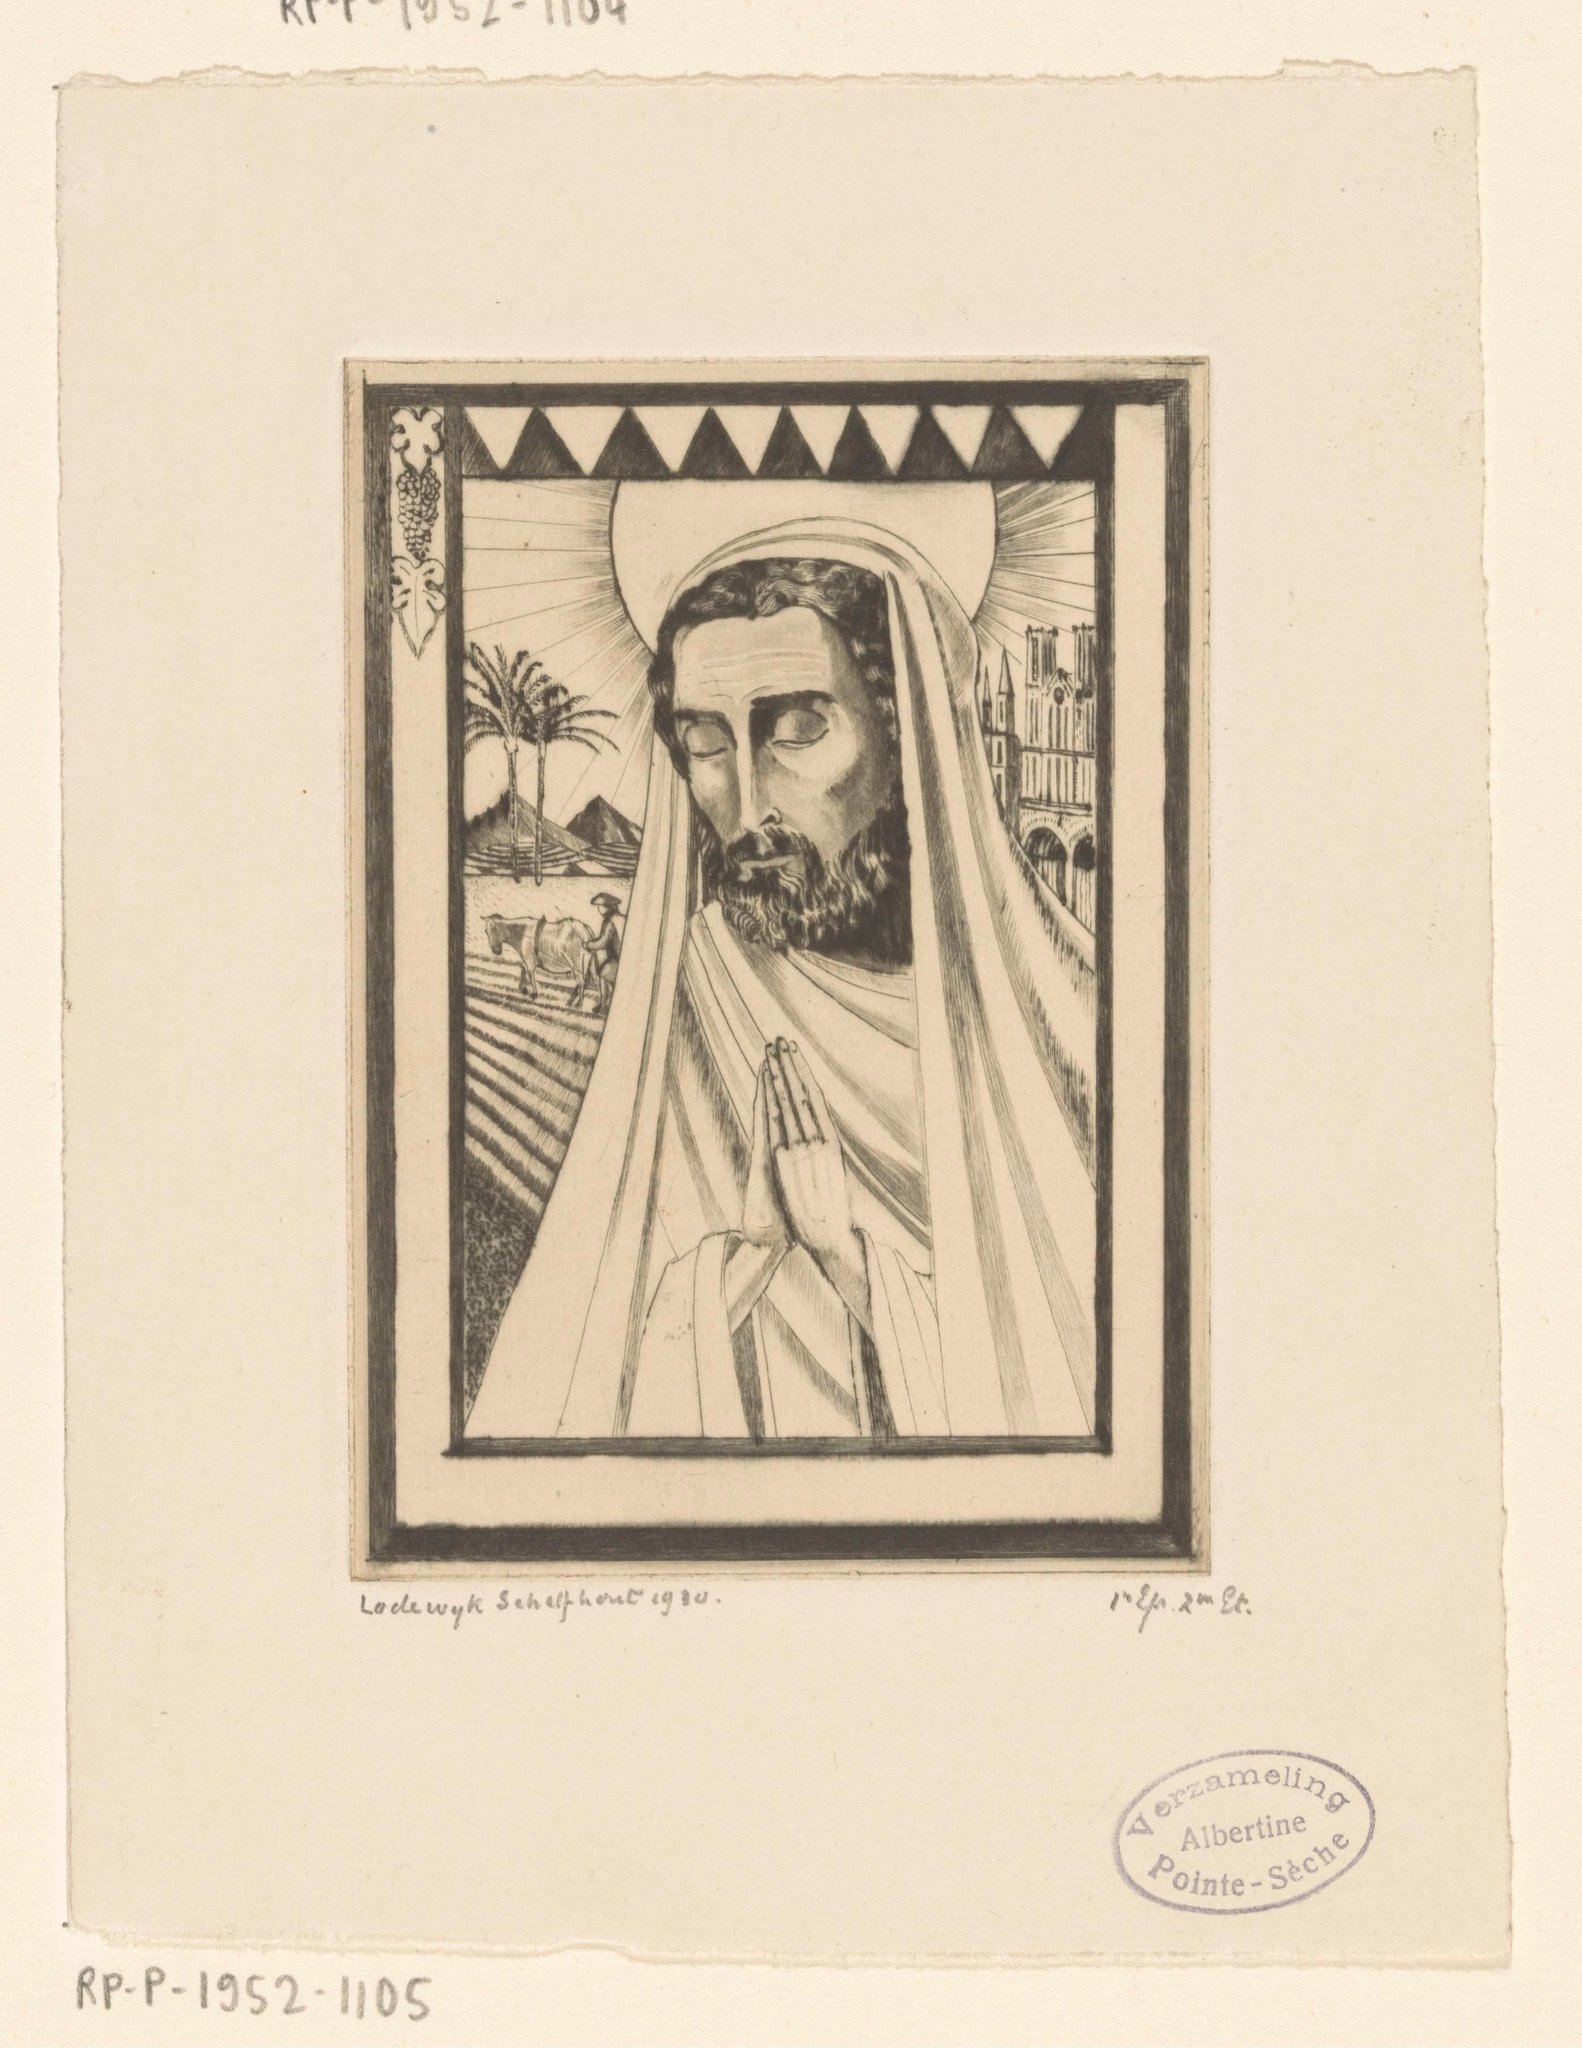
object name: print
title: St. Joseph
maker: lodewijk schelfhout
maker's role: draughtsman, print maker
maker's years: 1881-1943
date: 1930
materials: paper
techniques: drypoint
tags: the foster-father of christ, joseph of nazareth, husband of mary; possible attributes: flowering rod or wand, lily, carpenter's tools, one person praying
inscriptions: collector's mark: Lugt 2228, collector's mark: Lugt 2760, collector's mark: Lugt 5i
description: Jozef, met gevouwen handen en gesloten ogen. Bij deze tweede staat van de prent is er op de achtergrond een landschap met akker, palmbomen, bergen en kerken toegevoegd.